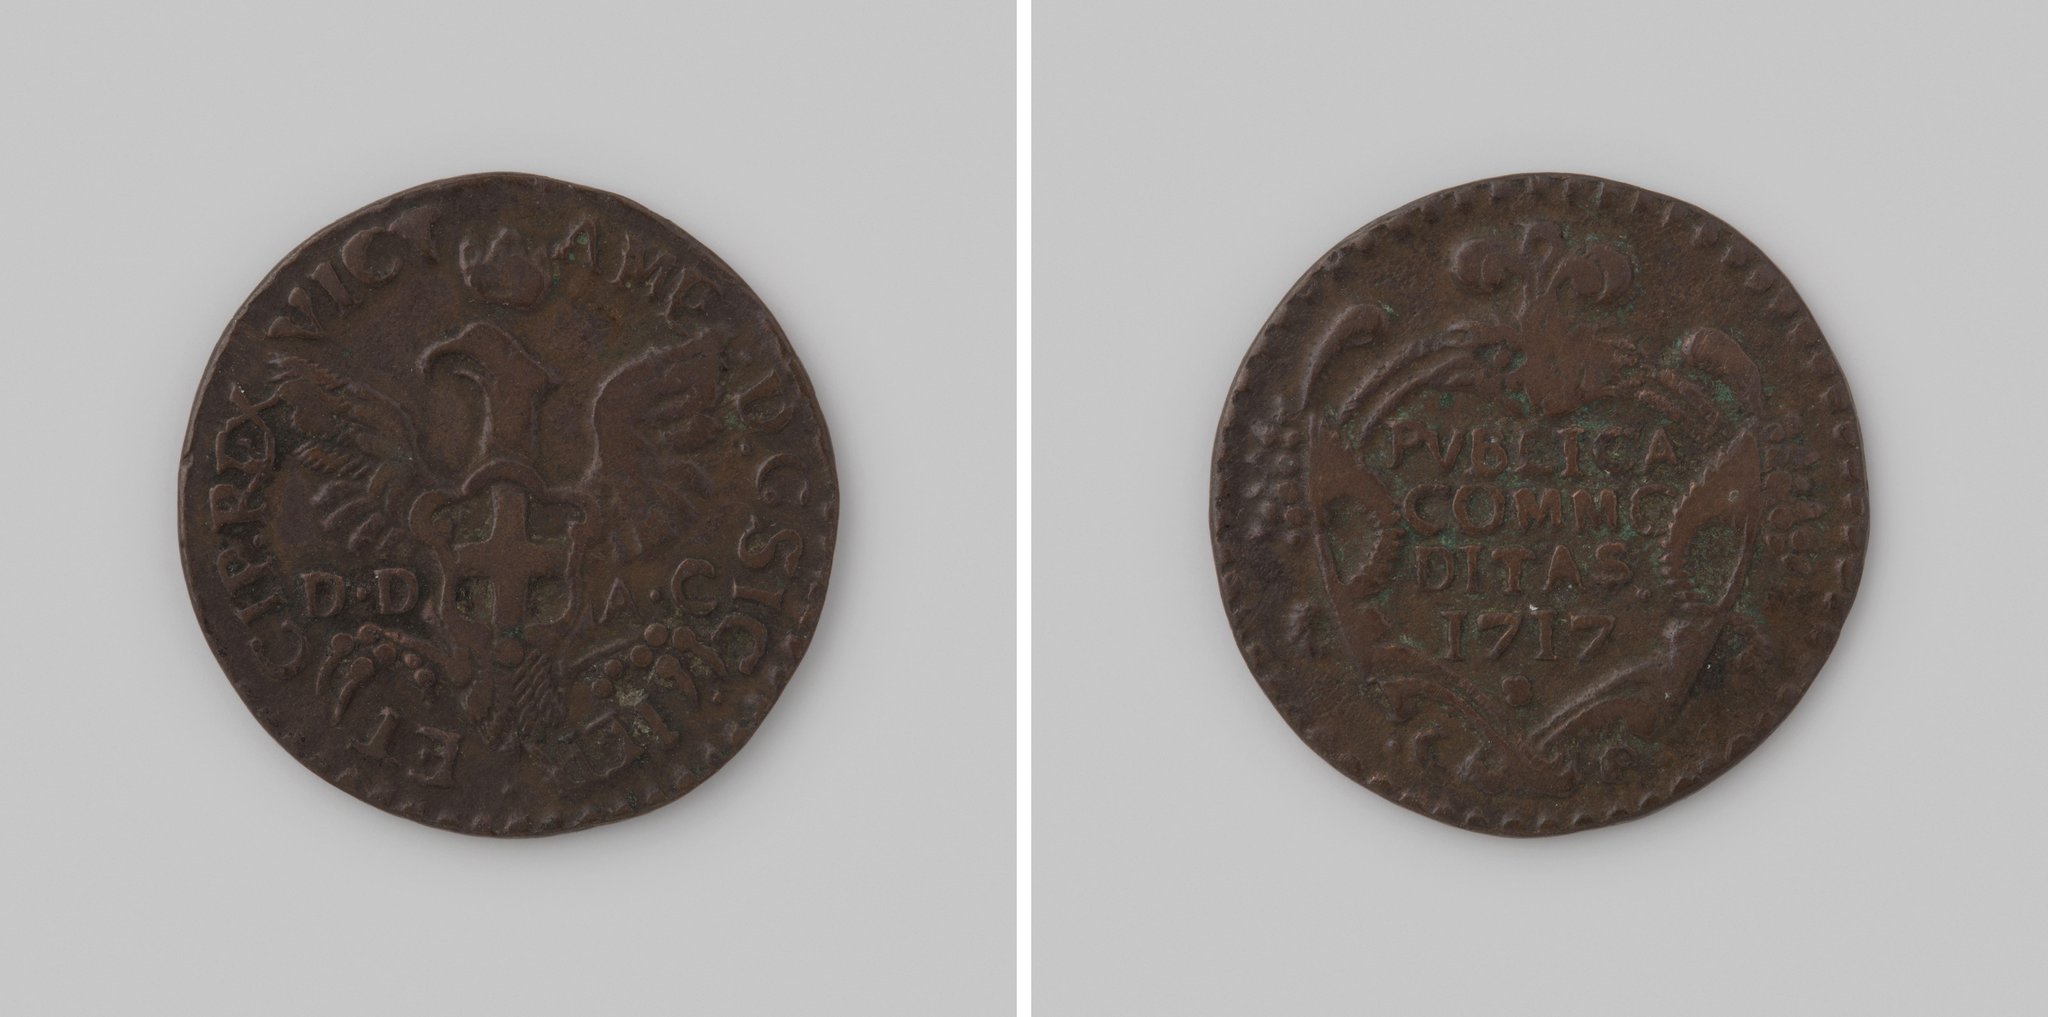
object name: coin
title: Sicilië, Vittorio Amadeo II van Savoie, grano, 1717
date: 1717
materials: copper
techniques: striking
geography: palermo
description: Koperen munt. Voorzijde: gekroonde adelaar met gespreide vleugels en op de borst het wapenschild van Savoie. Keerzijde: binnen een roccoco-versiering drieregelig opschrift, waaronder jaartal. Onderaan letters C en P [=Palermo]. Gladde rand.